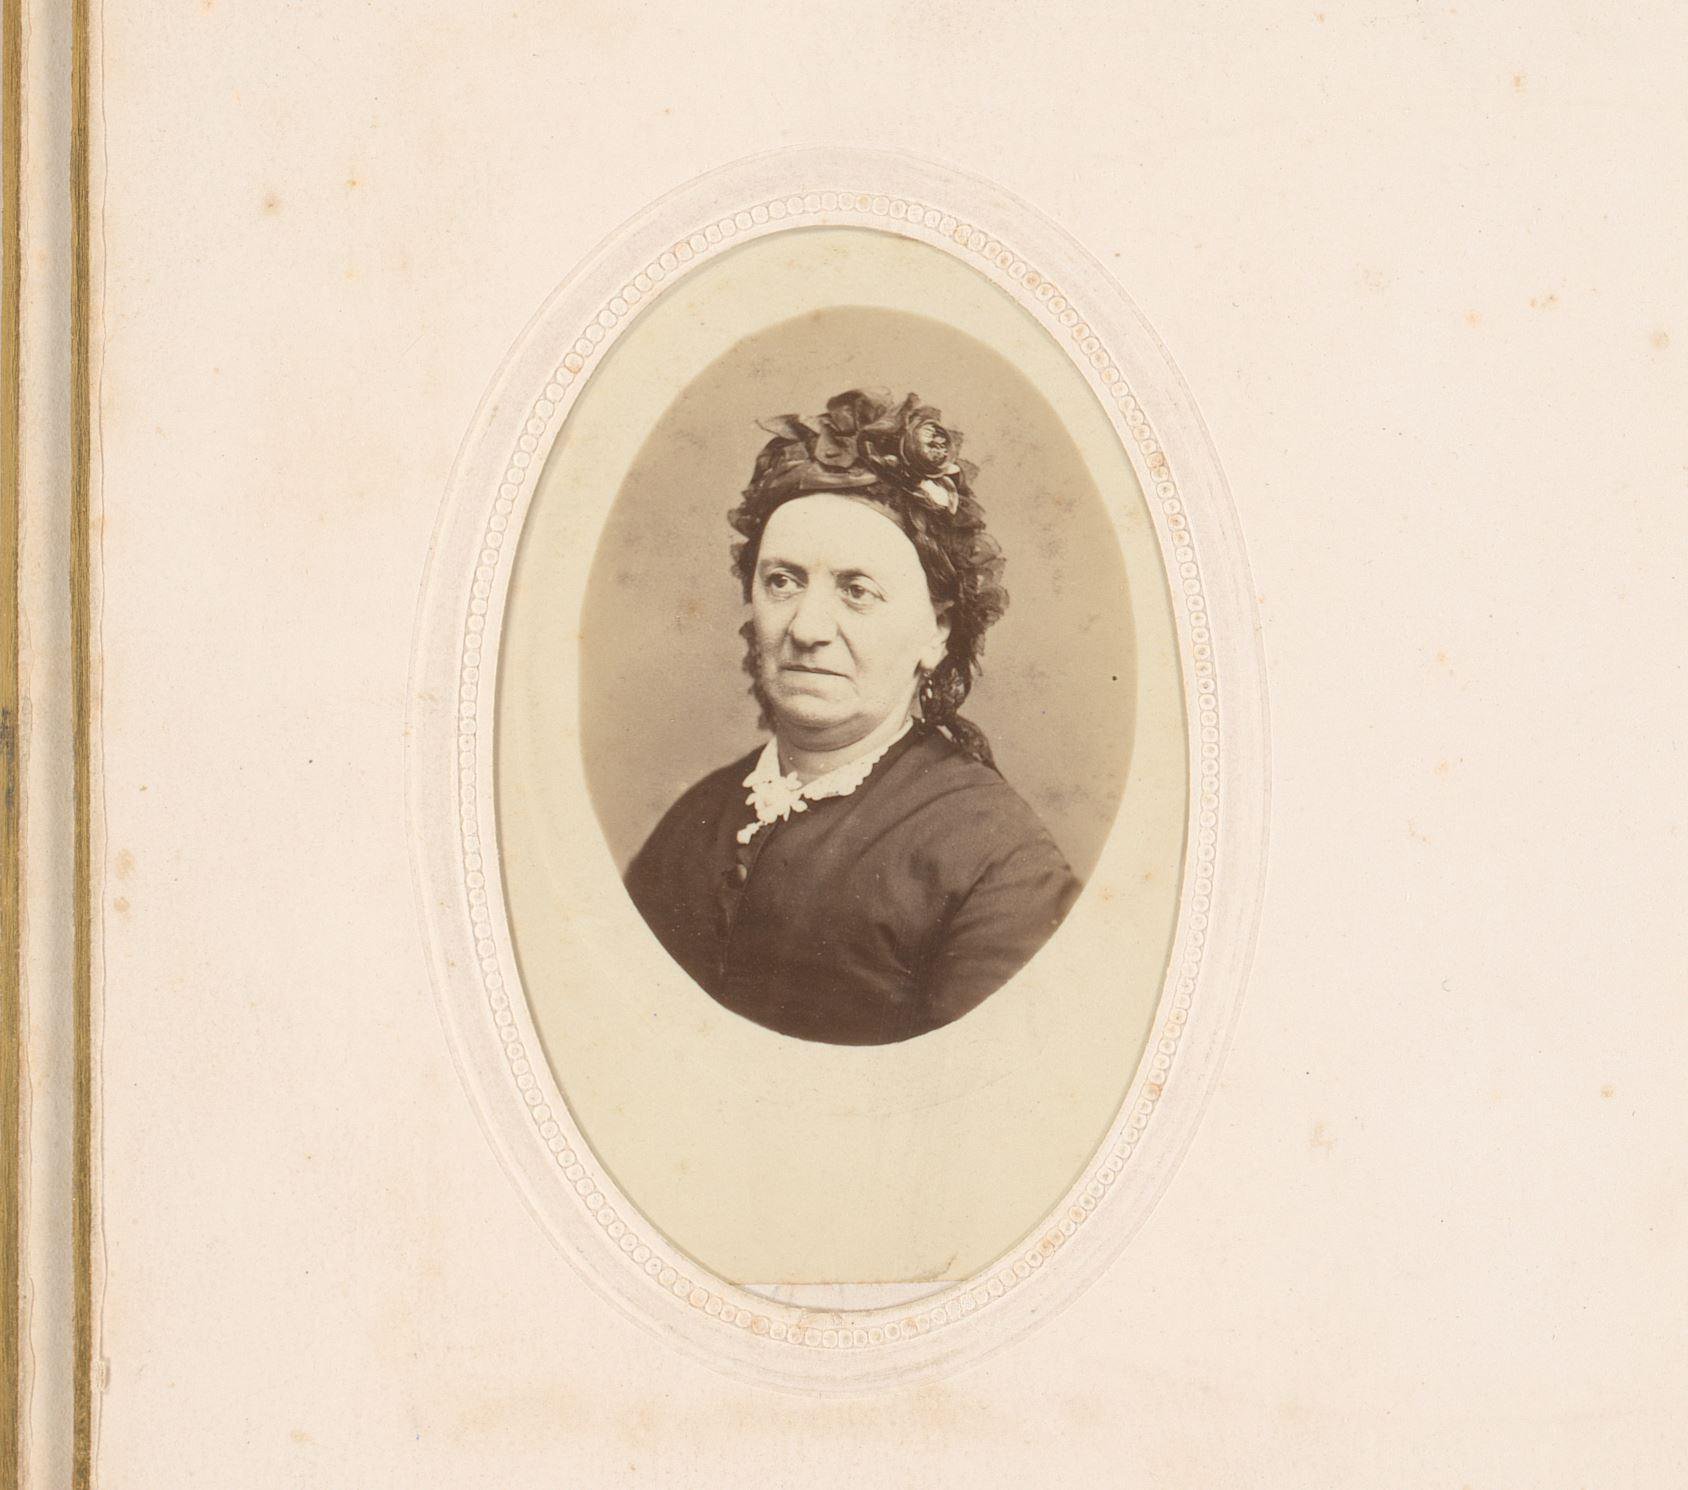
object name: album leaf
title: Portret van een vrouw met muts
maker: gerrit dirk siewers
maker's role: fotograaf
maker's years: 1846-1899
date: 1871-1891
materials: cardboard, paper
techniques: albumen print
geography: hoorn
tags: historical persons - bb - woman, head-gear: cap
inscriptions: inscription: ‘Photographe/ van/ G. D. SIEWERS/ DAGELIJKS WERKZAAM/ ACHTER DE GROOTE KERK./ HOORN.’